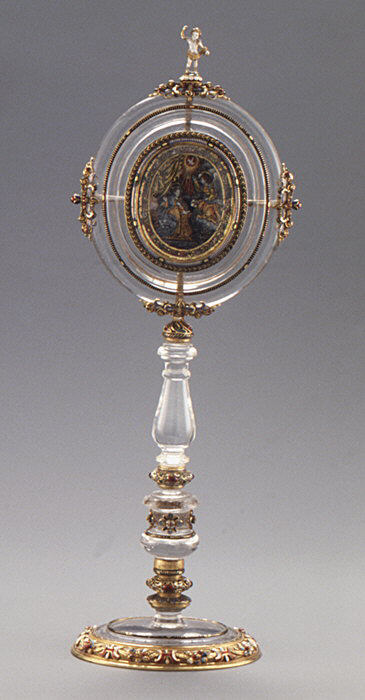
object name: reliquary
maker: reinhold vasters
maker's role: designer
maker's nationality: german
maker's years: 1827-1909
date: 1851-1900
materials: enamel, gold, quartz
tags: human figures,reliquaries